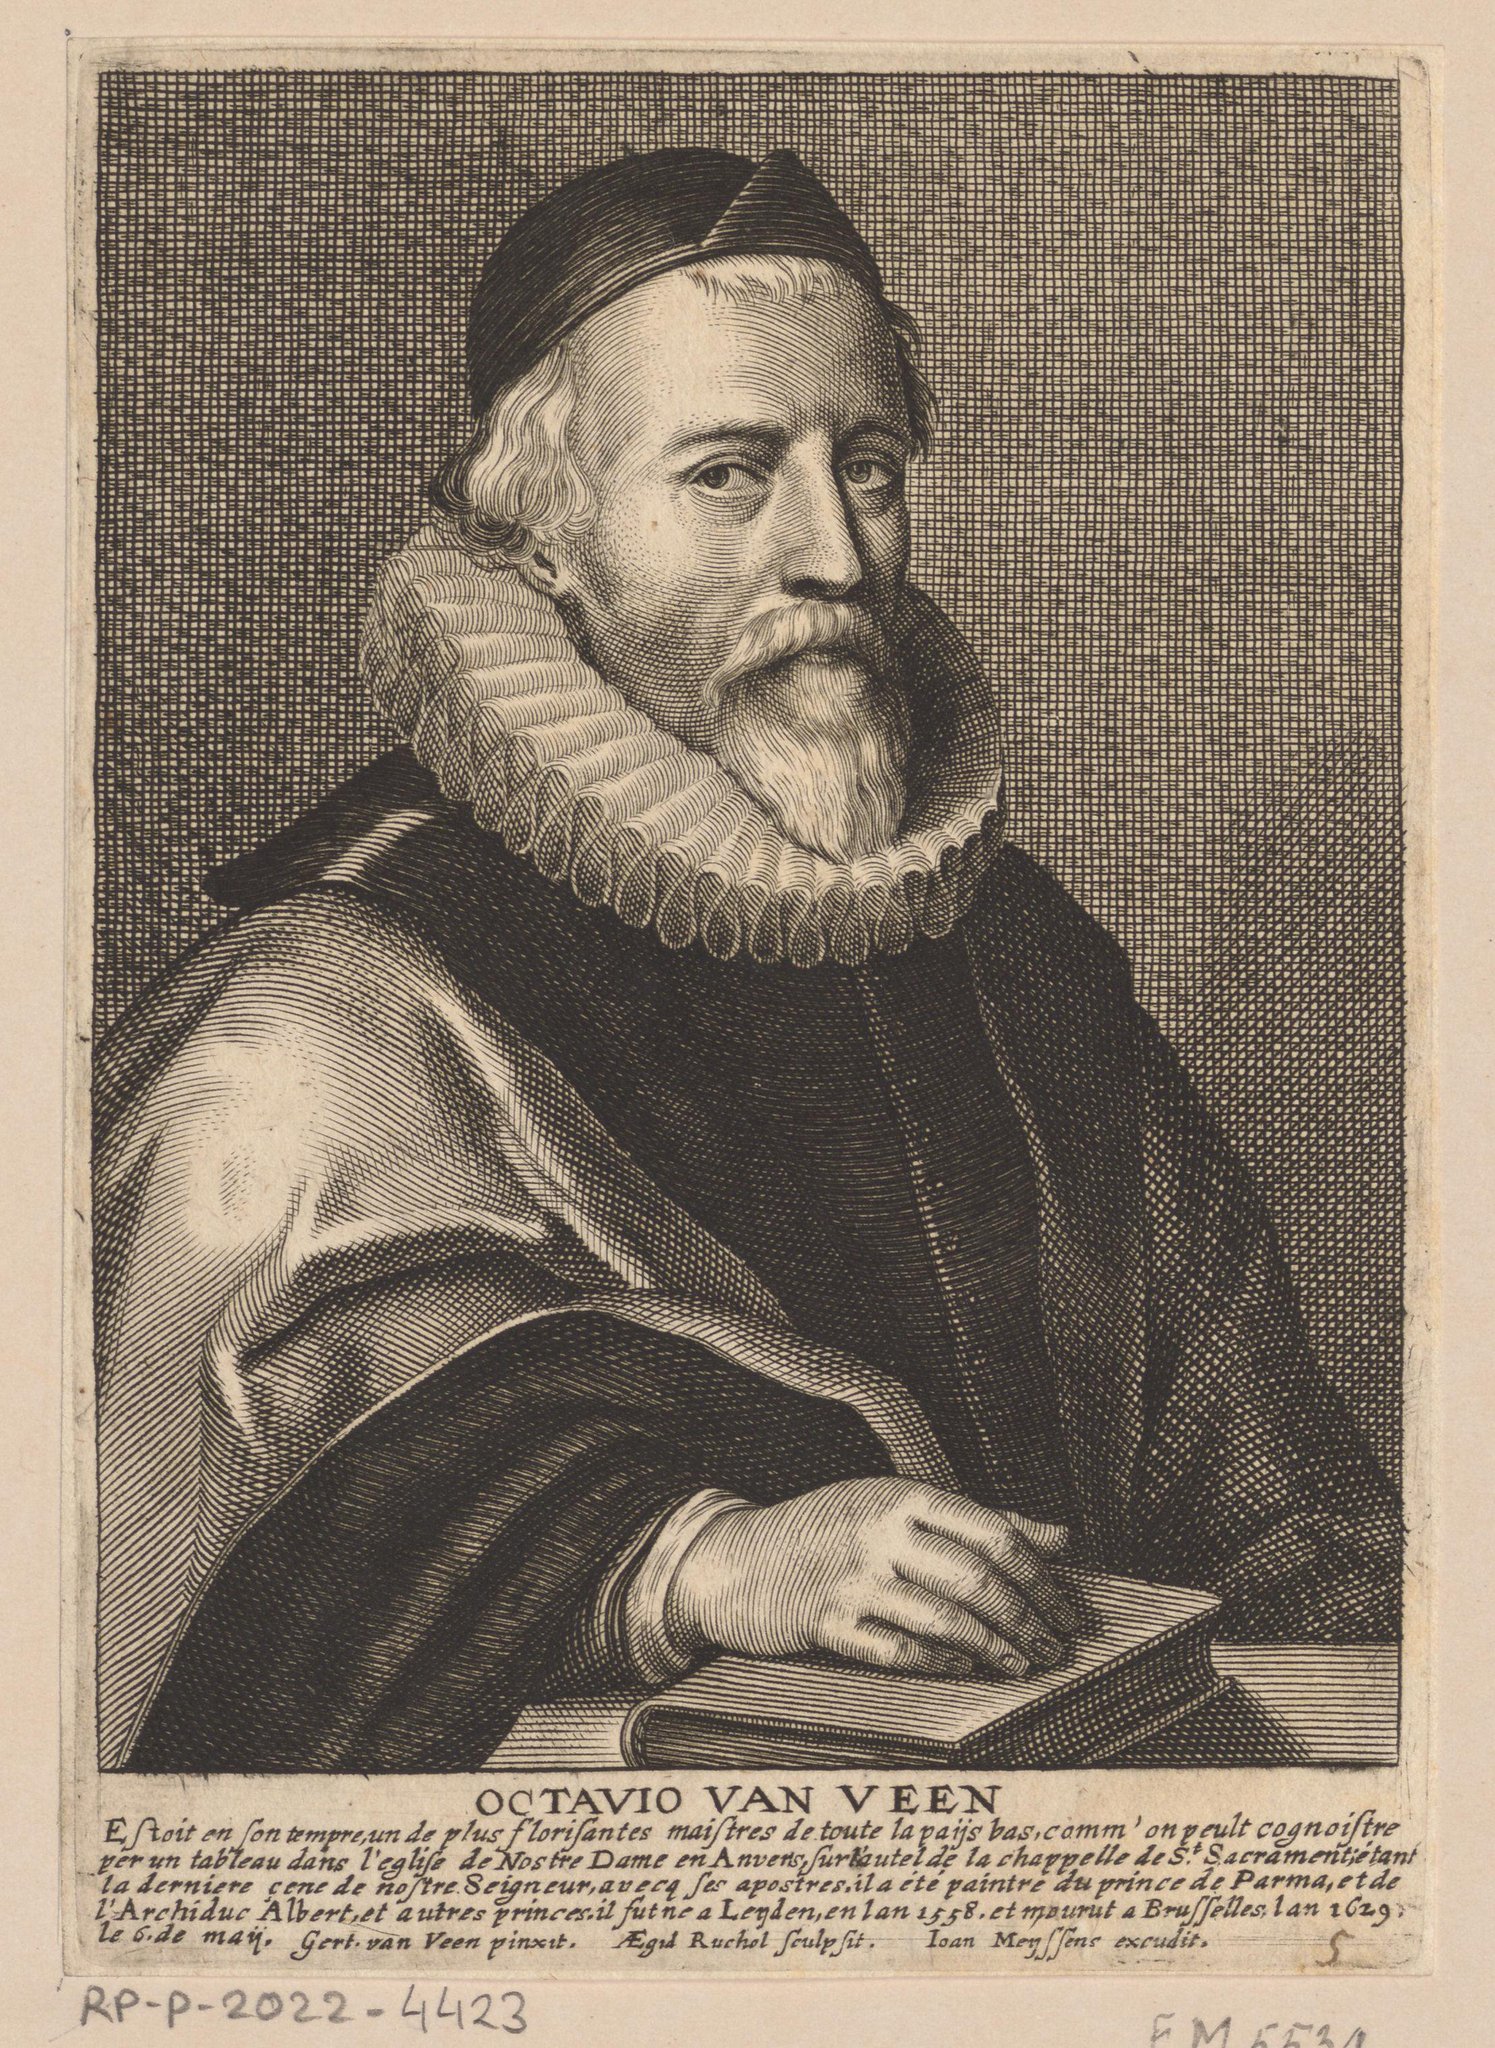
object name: print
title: Portret van Otto van Veen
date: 1661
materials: paper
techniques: engraving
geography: antwerp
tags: leiden, brussels, draughtsman, otto van veen, historical persons, portrait, self-portrait of painter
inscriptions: number: ‘5’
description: Prent met tekst op verso gebruikt in: Bie, Cornelis de. Het gulden Cabinet vande edel vry schilder const (...). Antwerpen: Joannes Meyssens, 1661.